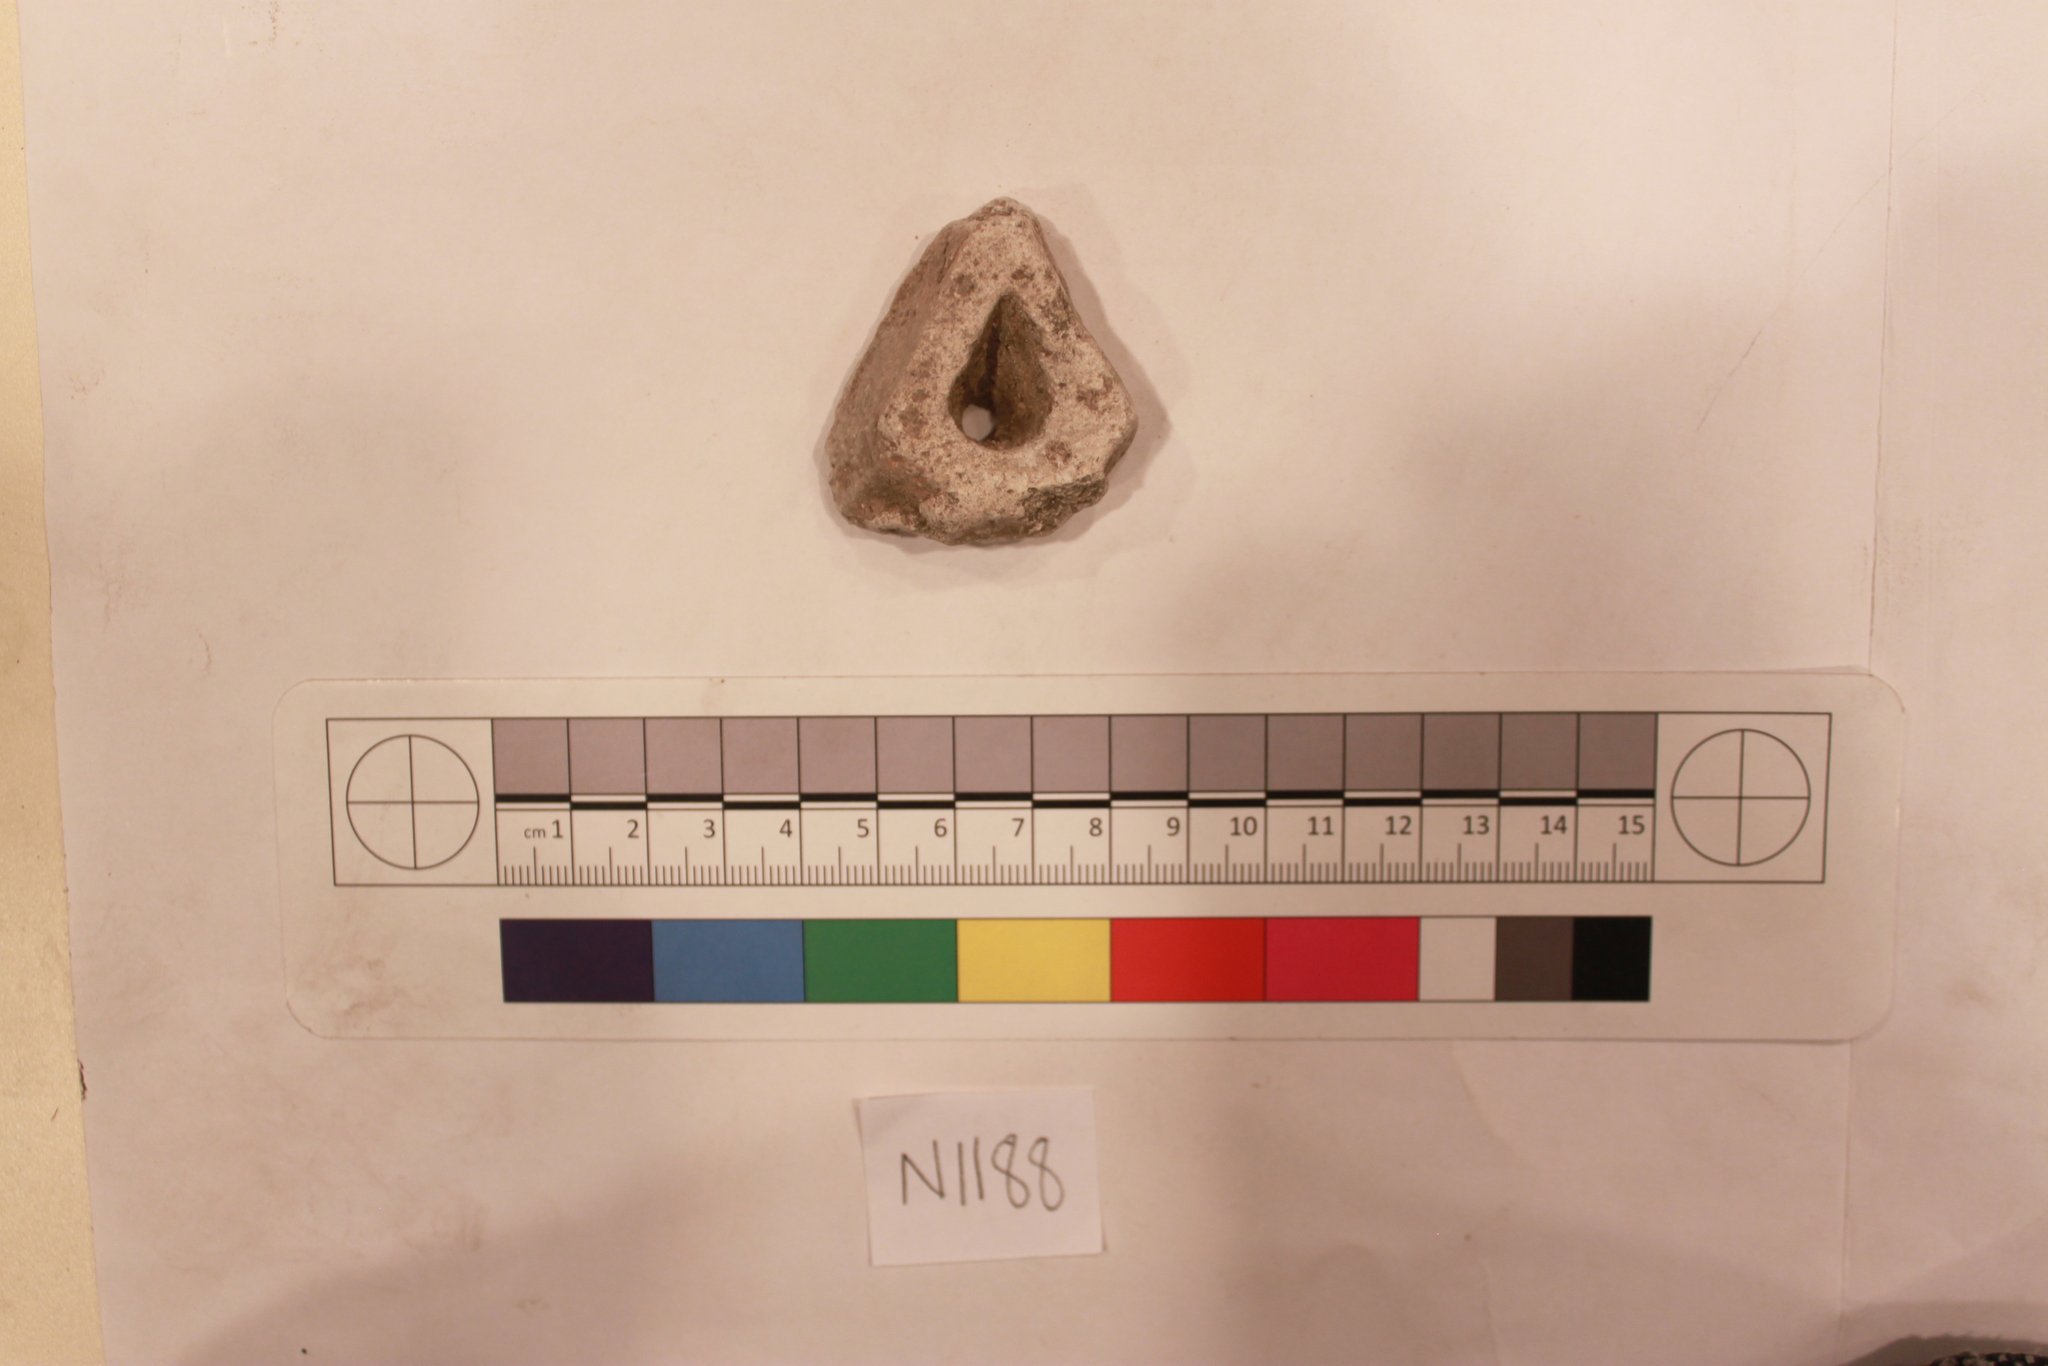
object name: fragment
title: Stucco Fragment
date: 701-1200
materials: plaster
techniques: carving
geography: iran